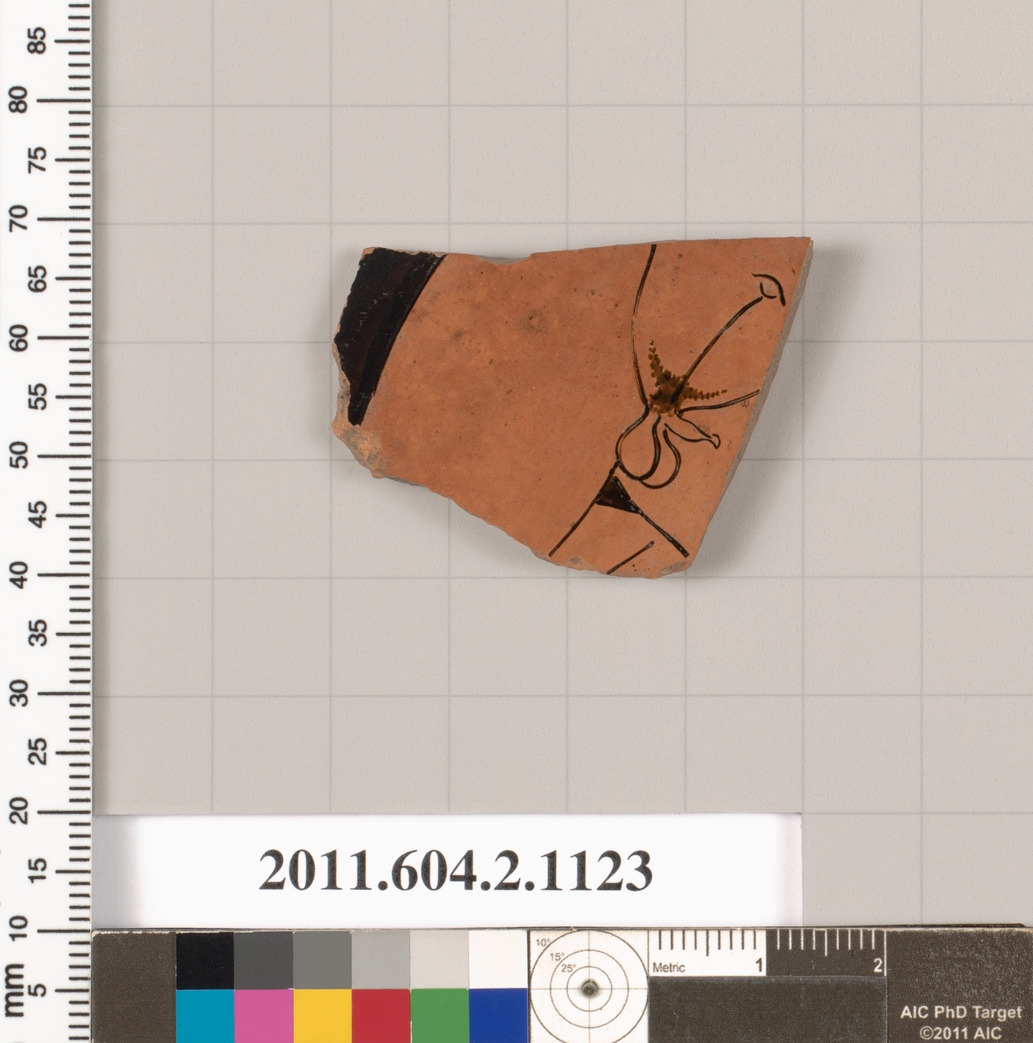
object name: lekythos fragment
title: Terracotta fragment of a lekythos (oil flask)?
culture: greek, attic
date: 500-480 BCE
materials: terracotta